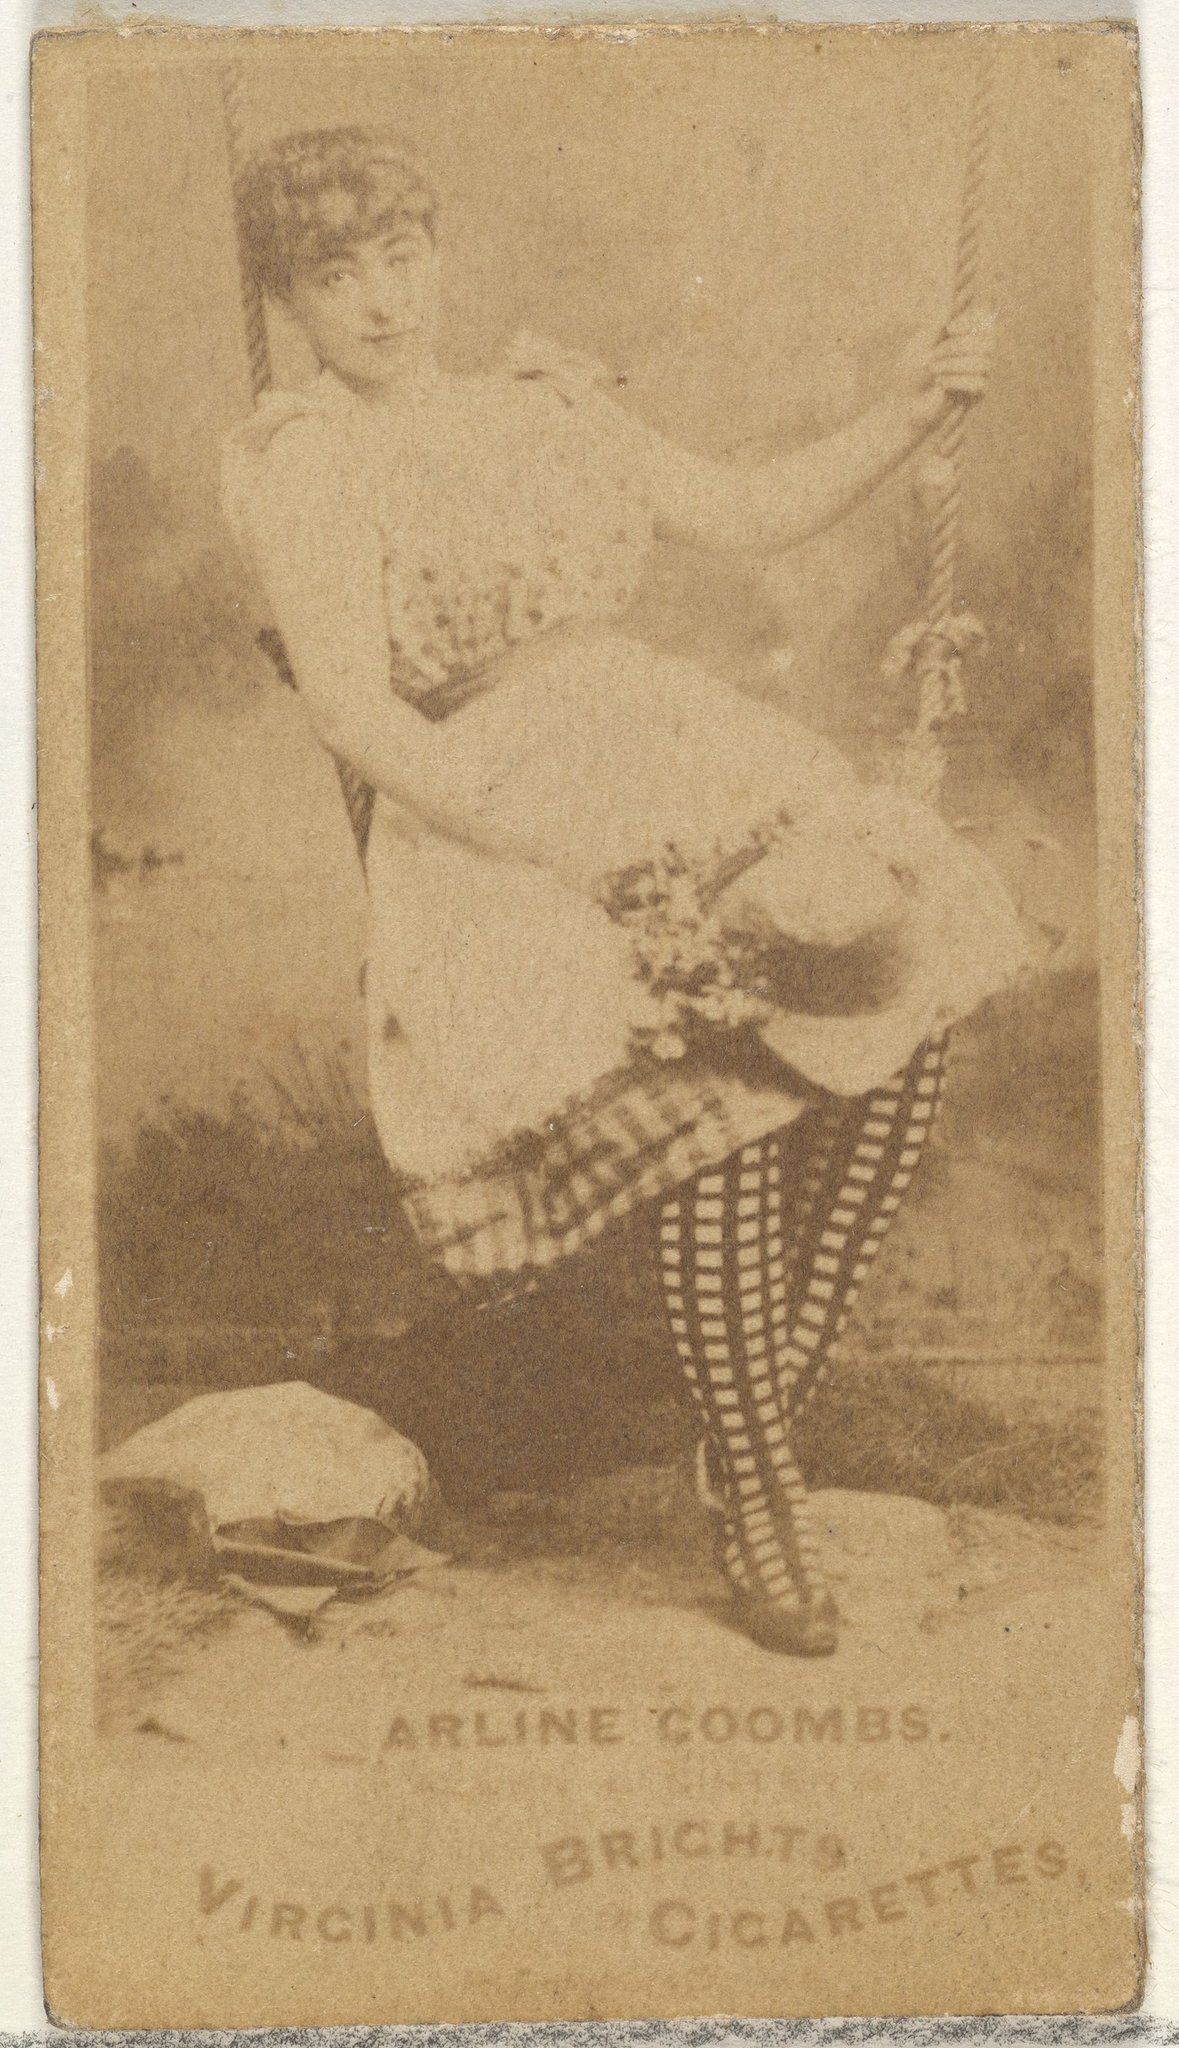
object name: photograph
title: Arline Coombs, from the Actors and Actresses series (N45, Type 1) for Virginia Brights Cigarettes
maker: allen & ginter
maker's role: publisher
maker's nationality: american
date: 1888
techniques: albumen silver print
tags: portraits,women,actresses